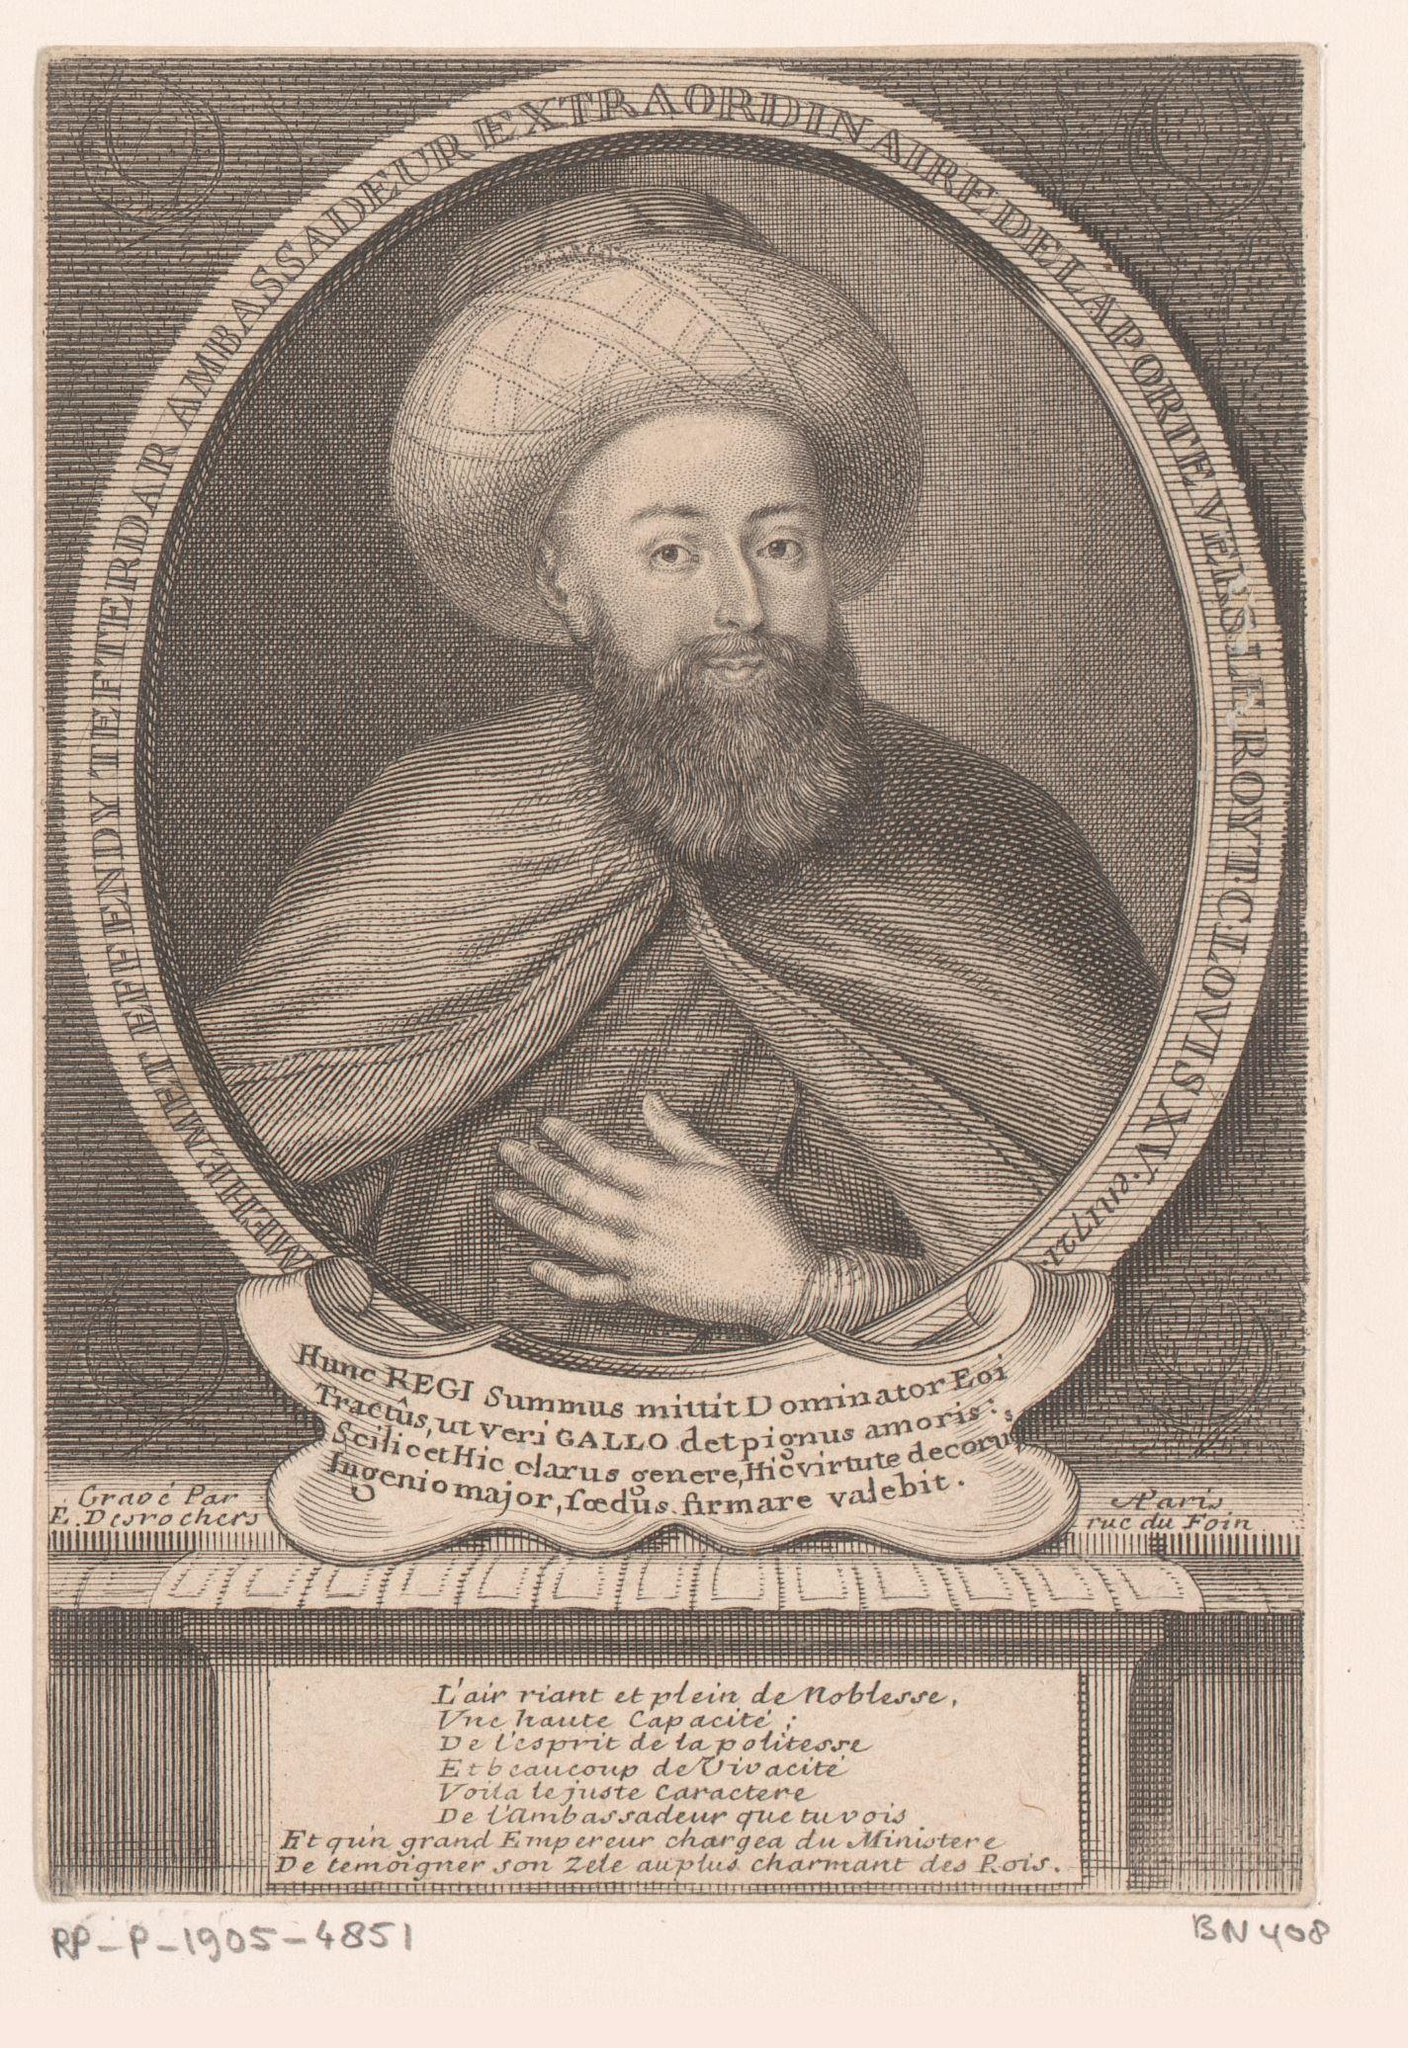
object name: print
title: Verzameling portretten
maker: étienne desrochers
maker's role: print maker, publisher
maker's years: 1668-1741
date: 1726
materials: paper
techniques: engraving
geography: paris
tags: historical persons, diplomacy, diplomat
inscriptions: collector's mark: Lugt 2228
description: Behoort waarschijnlijk tot een serie portretten, grotendeels door Etienne Desrochers, getiteld: 'Recueil de portraits de personnes qui se sont distinguées tant dans les Armes que dans Belles-Lettres et les Arts, comme aussi la famille royale de France et autres cours étrangères'. De serie werd initieel uitgegeven door Desrochers en aangekondigd in 'Mercure' in mei 1726, p. 985. Echter was Desrochers reeds enkele jaren eerder begonnen met het uitgeven van de serie. Na de dood van Desrochers werd de serie voortgezet door Gilles Edme Petit. Een latere staat werd uitgegeven door Jean François Daumont in Parijs.